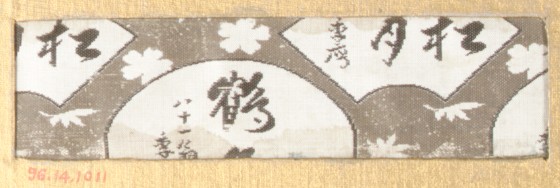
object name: piece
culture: japanese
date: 1701-1900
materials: silk